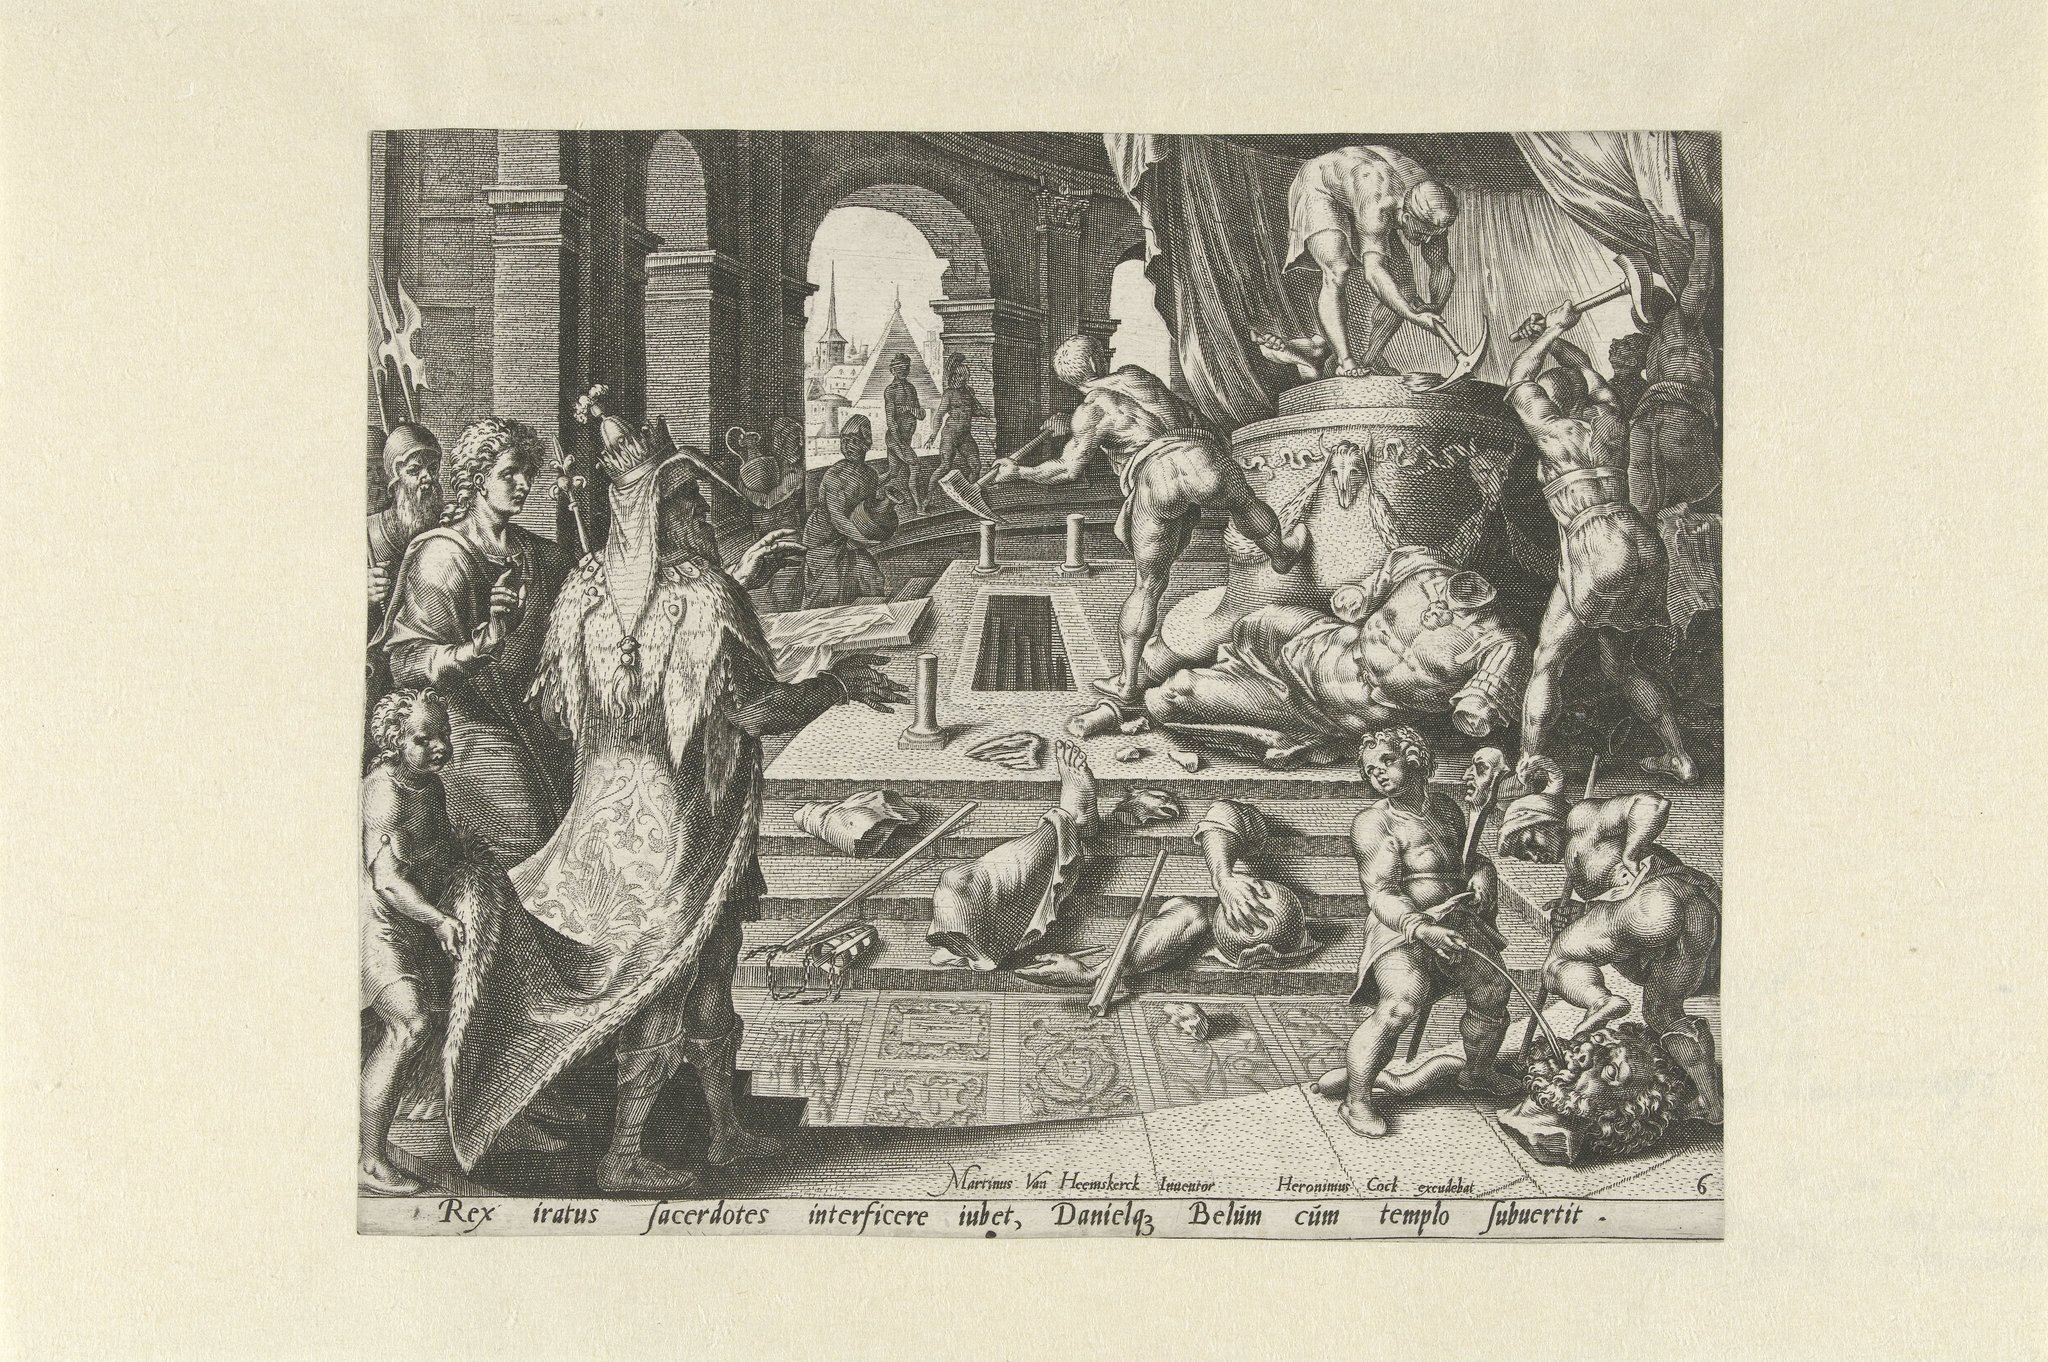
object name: print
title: Koning Cyrus laat het beeld van Bel aan stukken slaan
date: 1565-1601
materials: paper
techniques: engraving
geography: antwerp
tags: daniel destroys the temple of bel and its image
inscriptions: collector's mark: Lugt 2228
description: Koning Cyrus kijkt hoe mannen het beeld van de god Bel aan stukken slaan. Op de plek waar de tafel met eten stond is nu de ingang van de geheime toegang tot de tempel te zien. Rechtsvoor plast een jongetje in de mond van Bel.